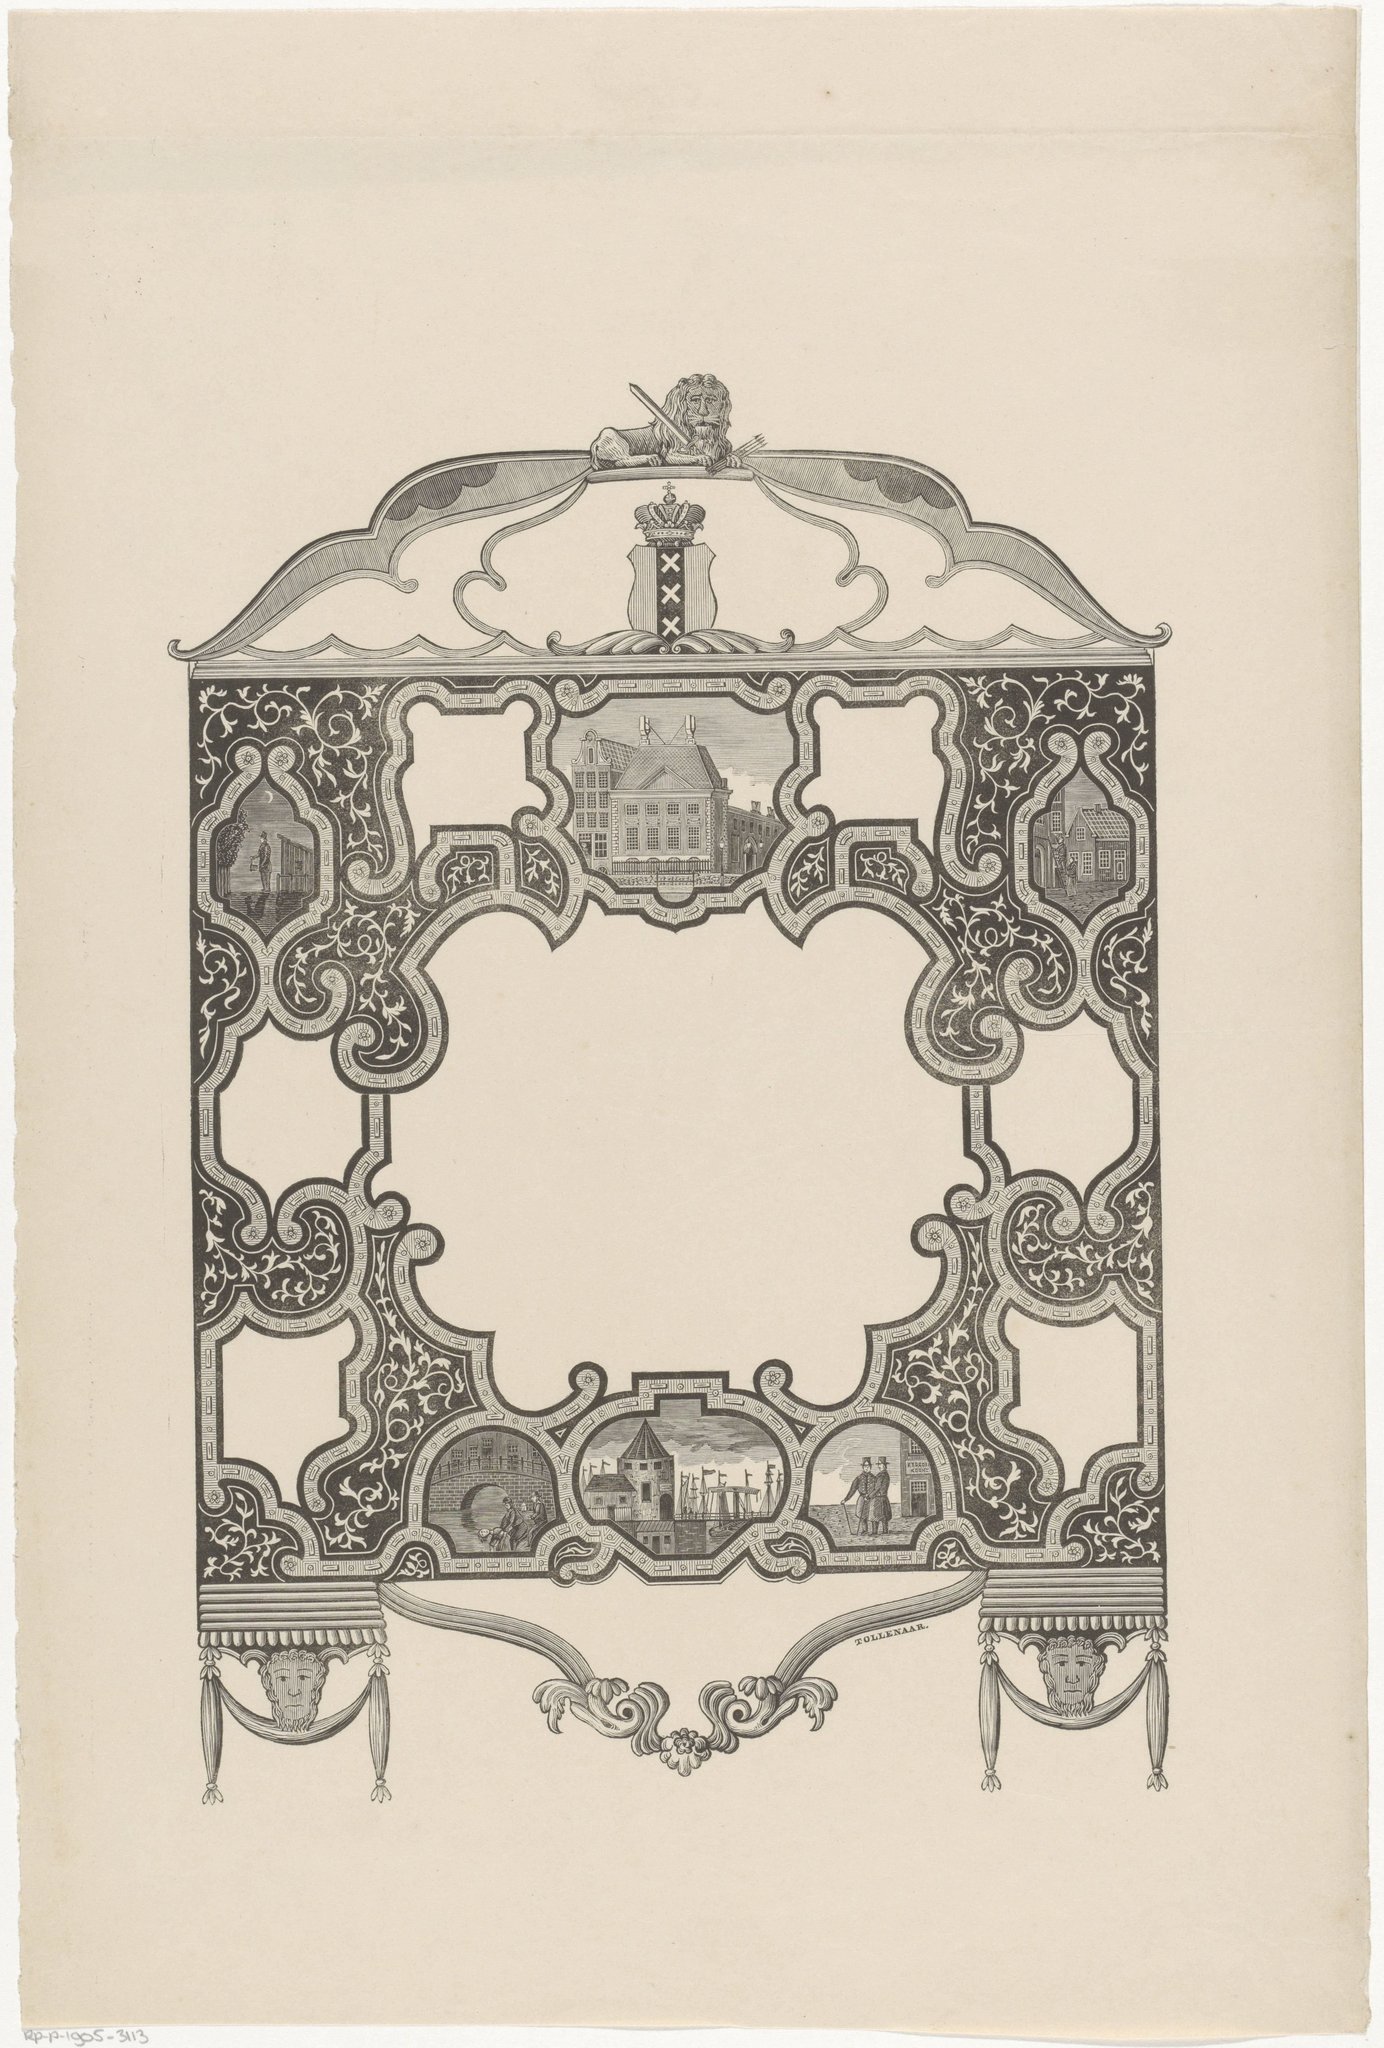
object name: print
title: Geornamenteerde omlijsting met zes stadsgezichten te Amsterdam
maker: antonie vink tollenaar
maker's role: print maker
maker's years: 1805-1875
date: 1815-1875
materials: paper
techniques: engraving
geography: netherlands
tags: square, place, circus, etc., street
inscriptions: collector's mark: Lugt 2228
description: Zes stadsgezichten te Amsterdam, waaronder een gezicht op de Schreierstoren.